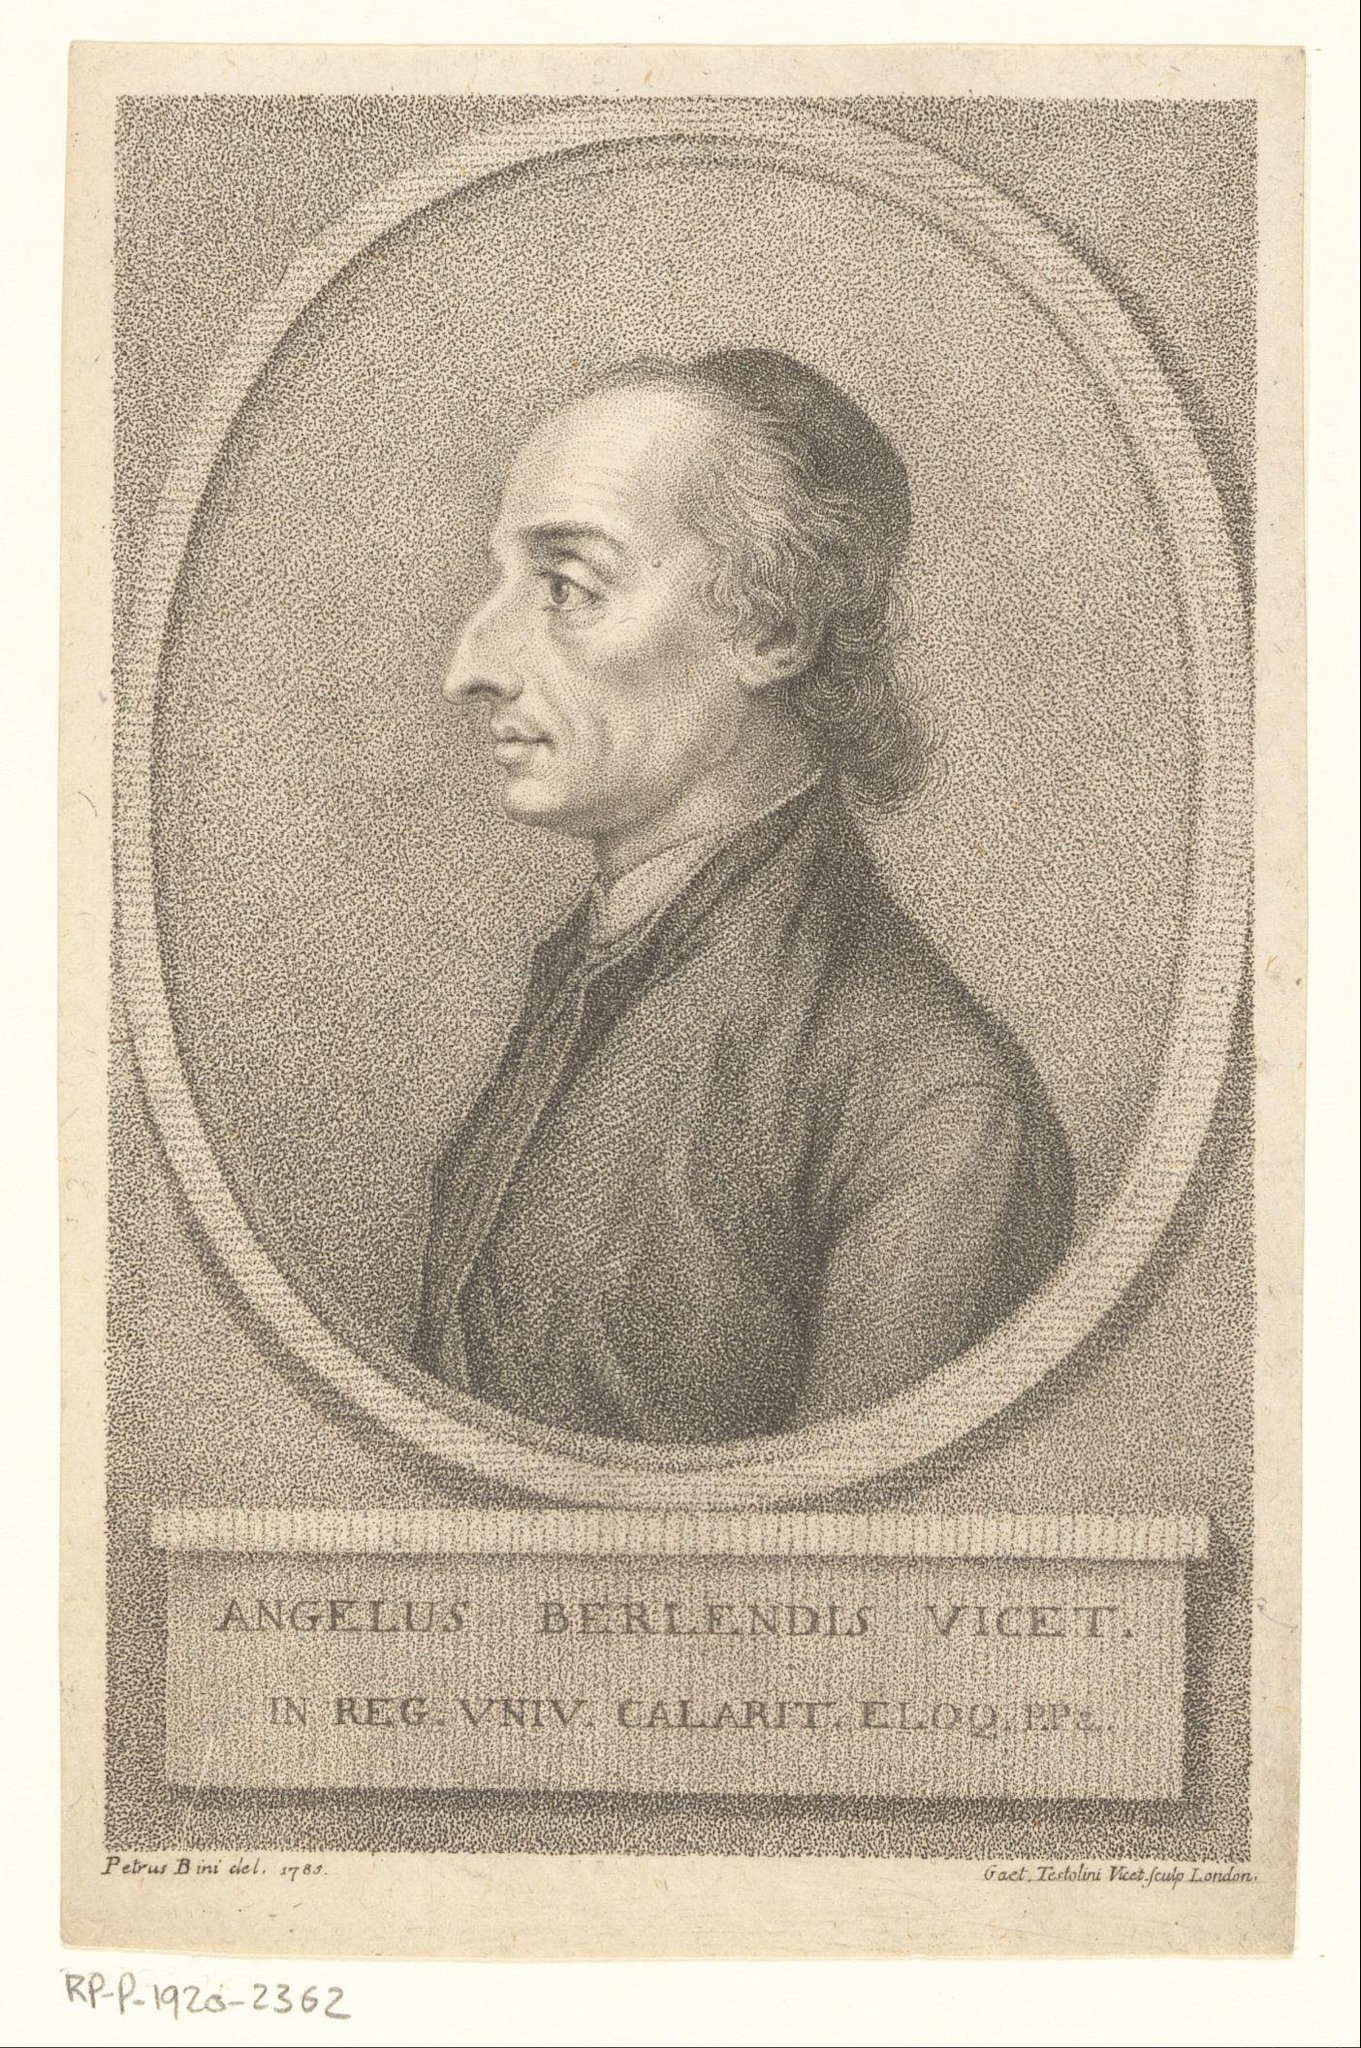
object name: print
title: Portret van Angelus Berlendis Vicet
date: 1785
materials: paper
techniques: engraving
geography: london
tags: historical persons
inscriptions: collector's mark: Lugt 2228